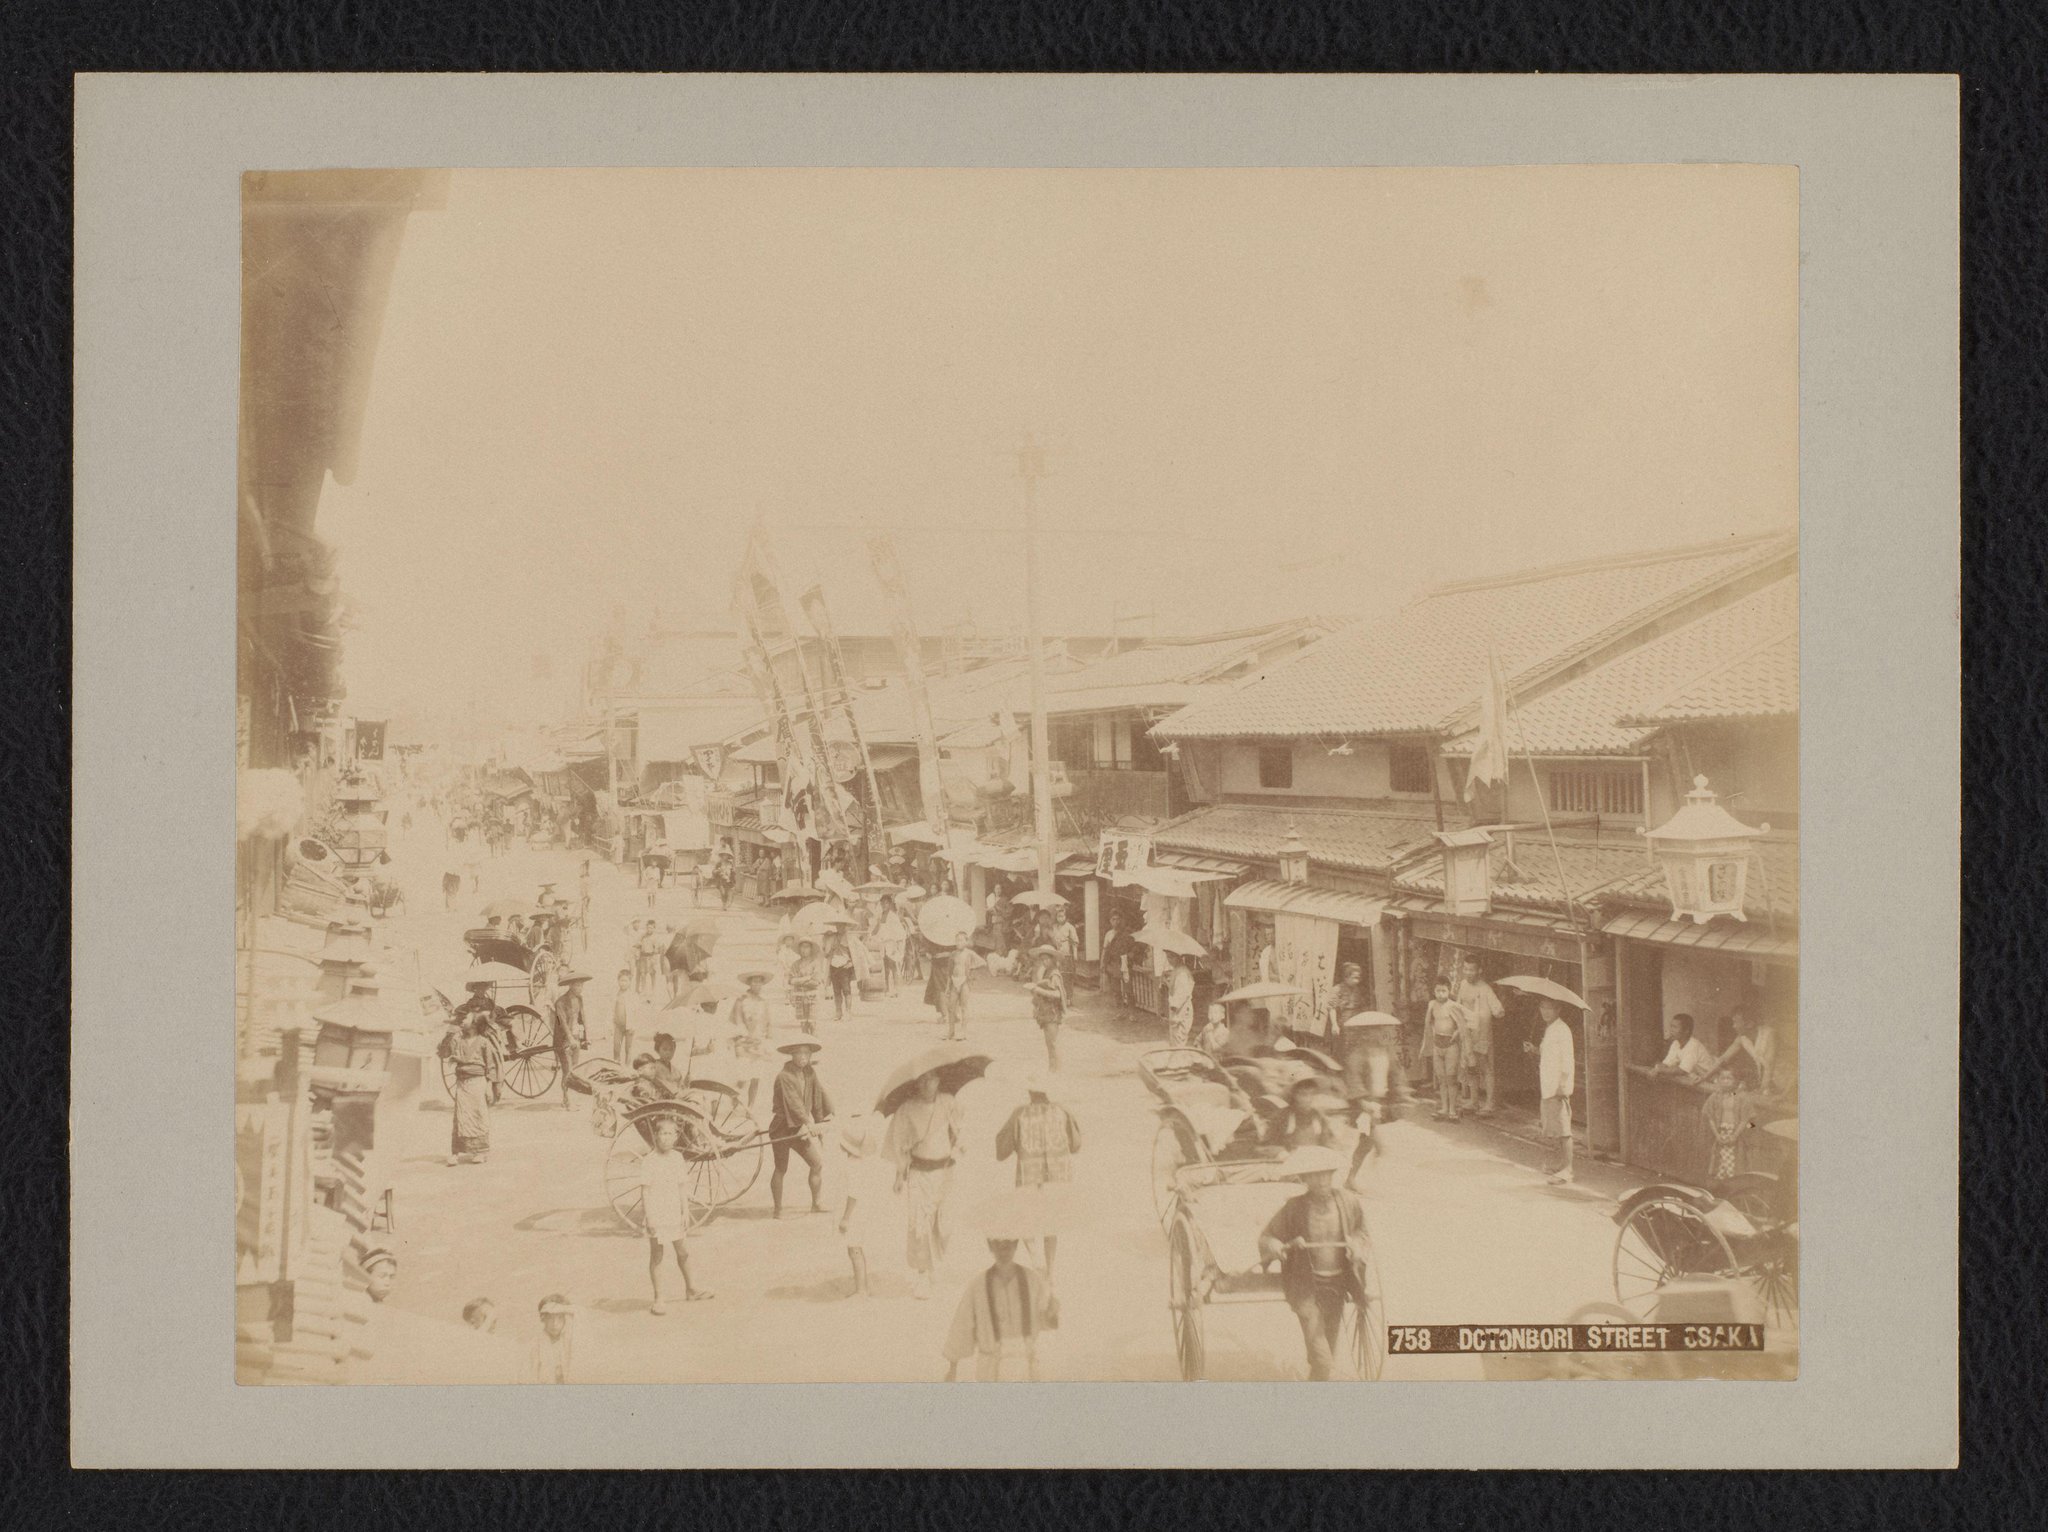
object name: photograph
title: Dotonboristraat, Osaka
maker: Anonymous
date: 1895-1915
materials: cardboard, photographic support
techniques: albumen print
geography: osaka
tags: osaka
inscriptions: number: ‘3.’